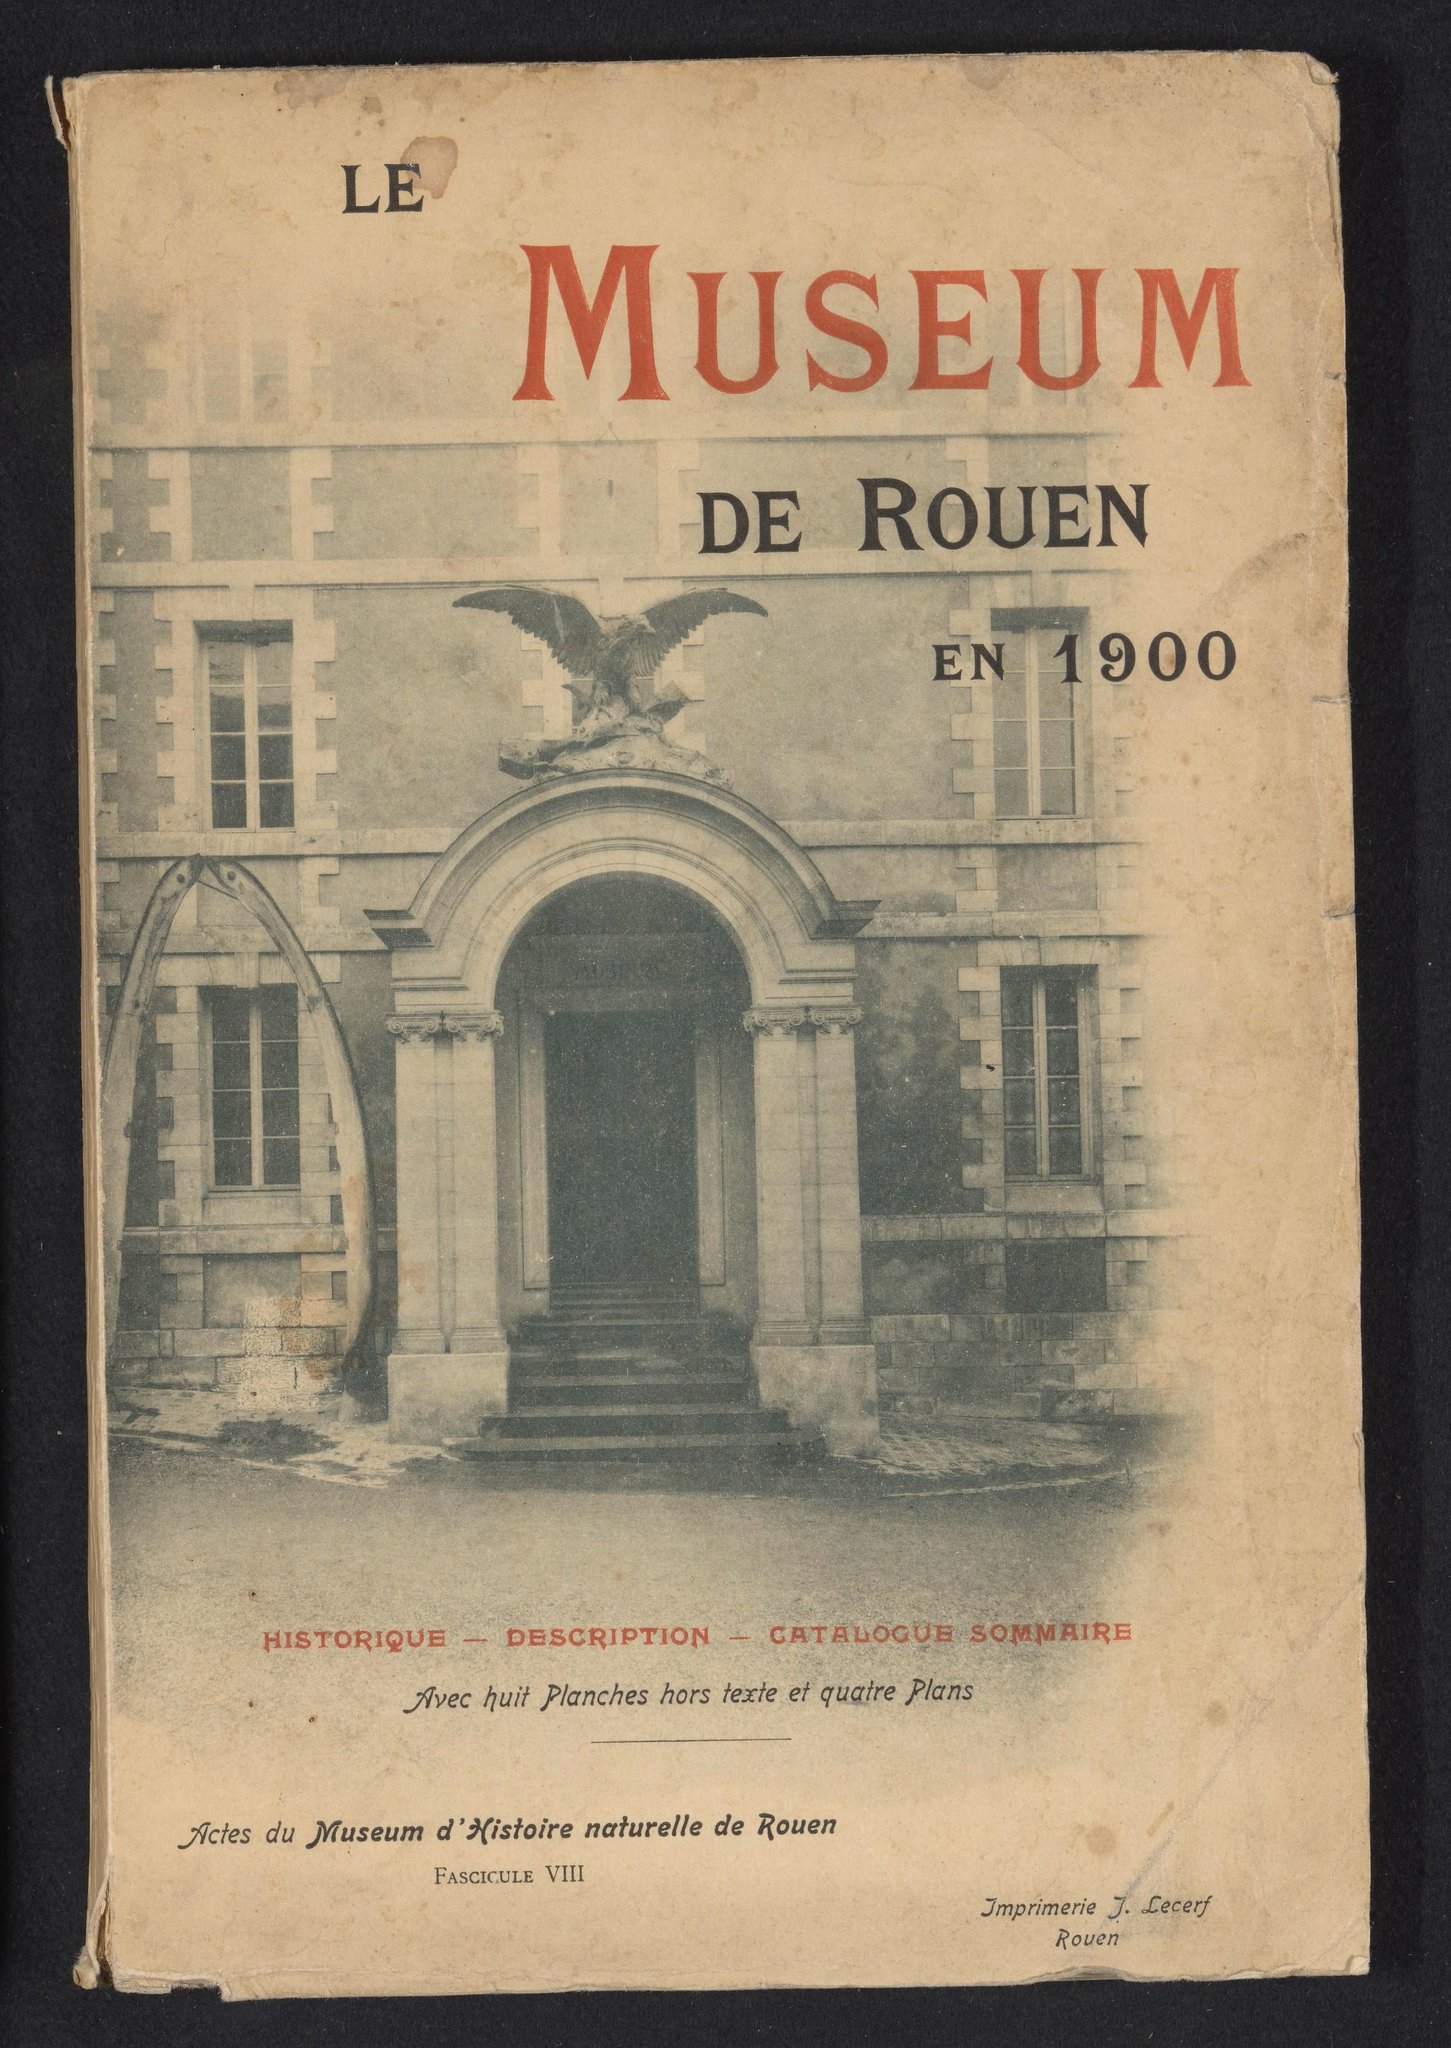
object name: photomechanical print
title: Le Museum de Rouen en 1900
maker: Anonymous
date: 1890-1900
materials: paper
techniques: photograph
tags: permanent exhibition, museum, façade (of house or building)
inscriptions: inscription: ‘Historique - Description - Catalogue sommaire Avec huit Planches hors texte et quatre Plans Actes du Museum d'Histoire naturelle de Rouen Fascicule VIII’